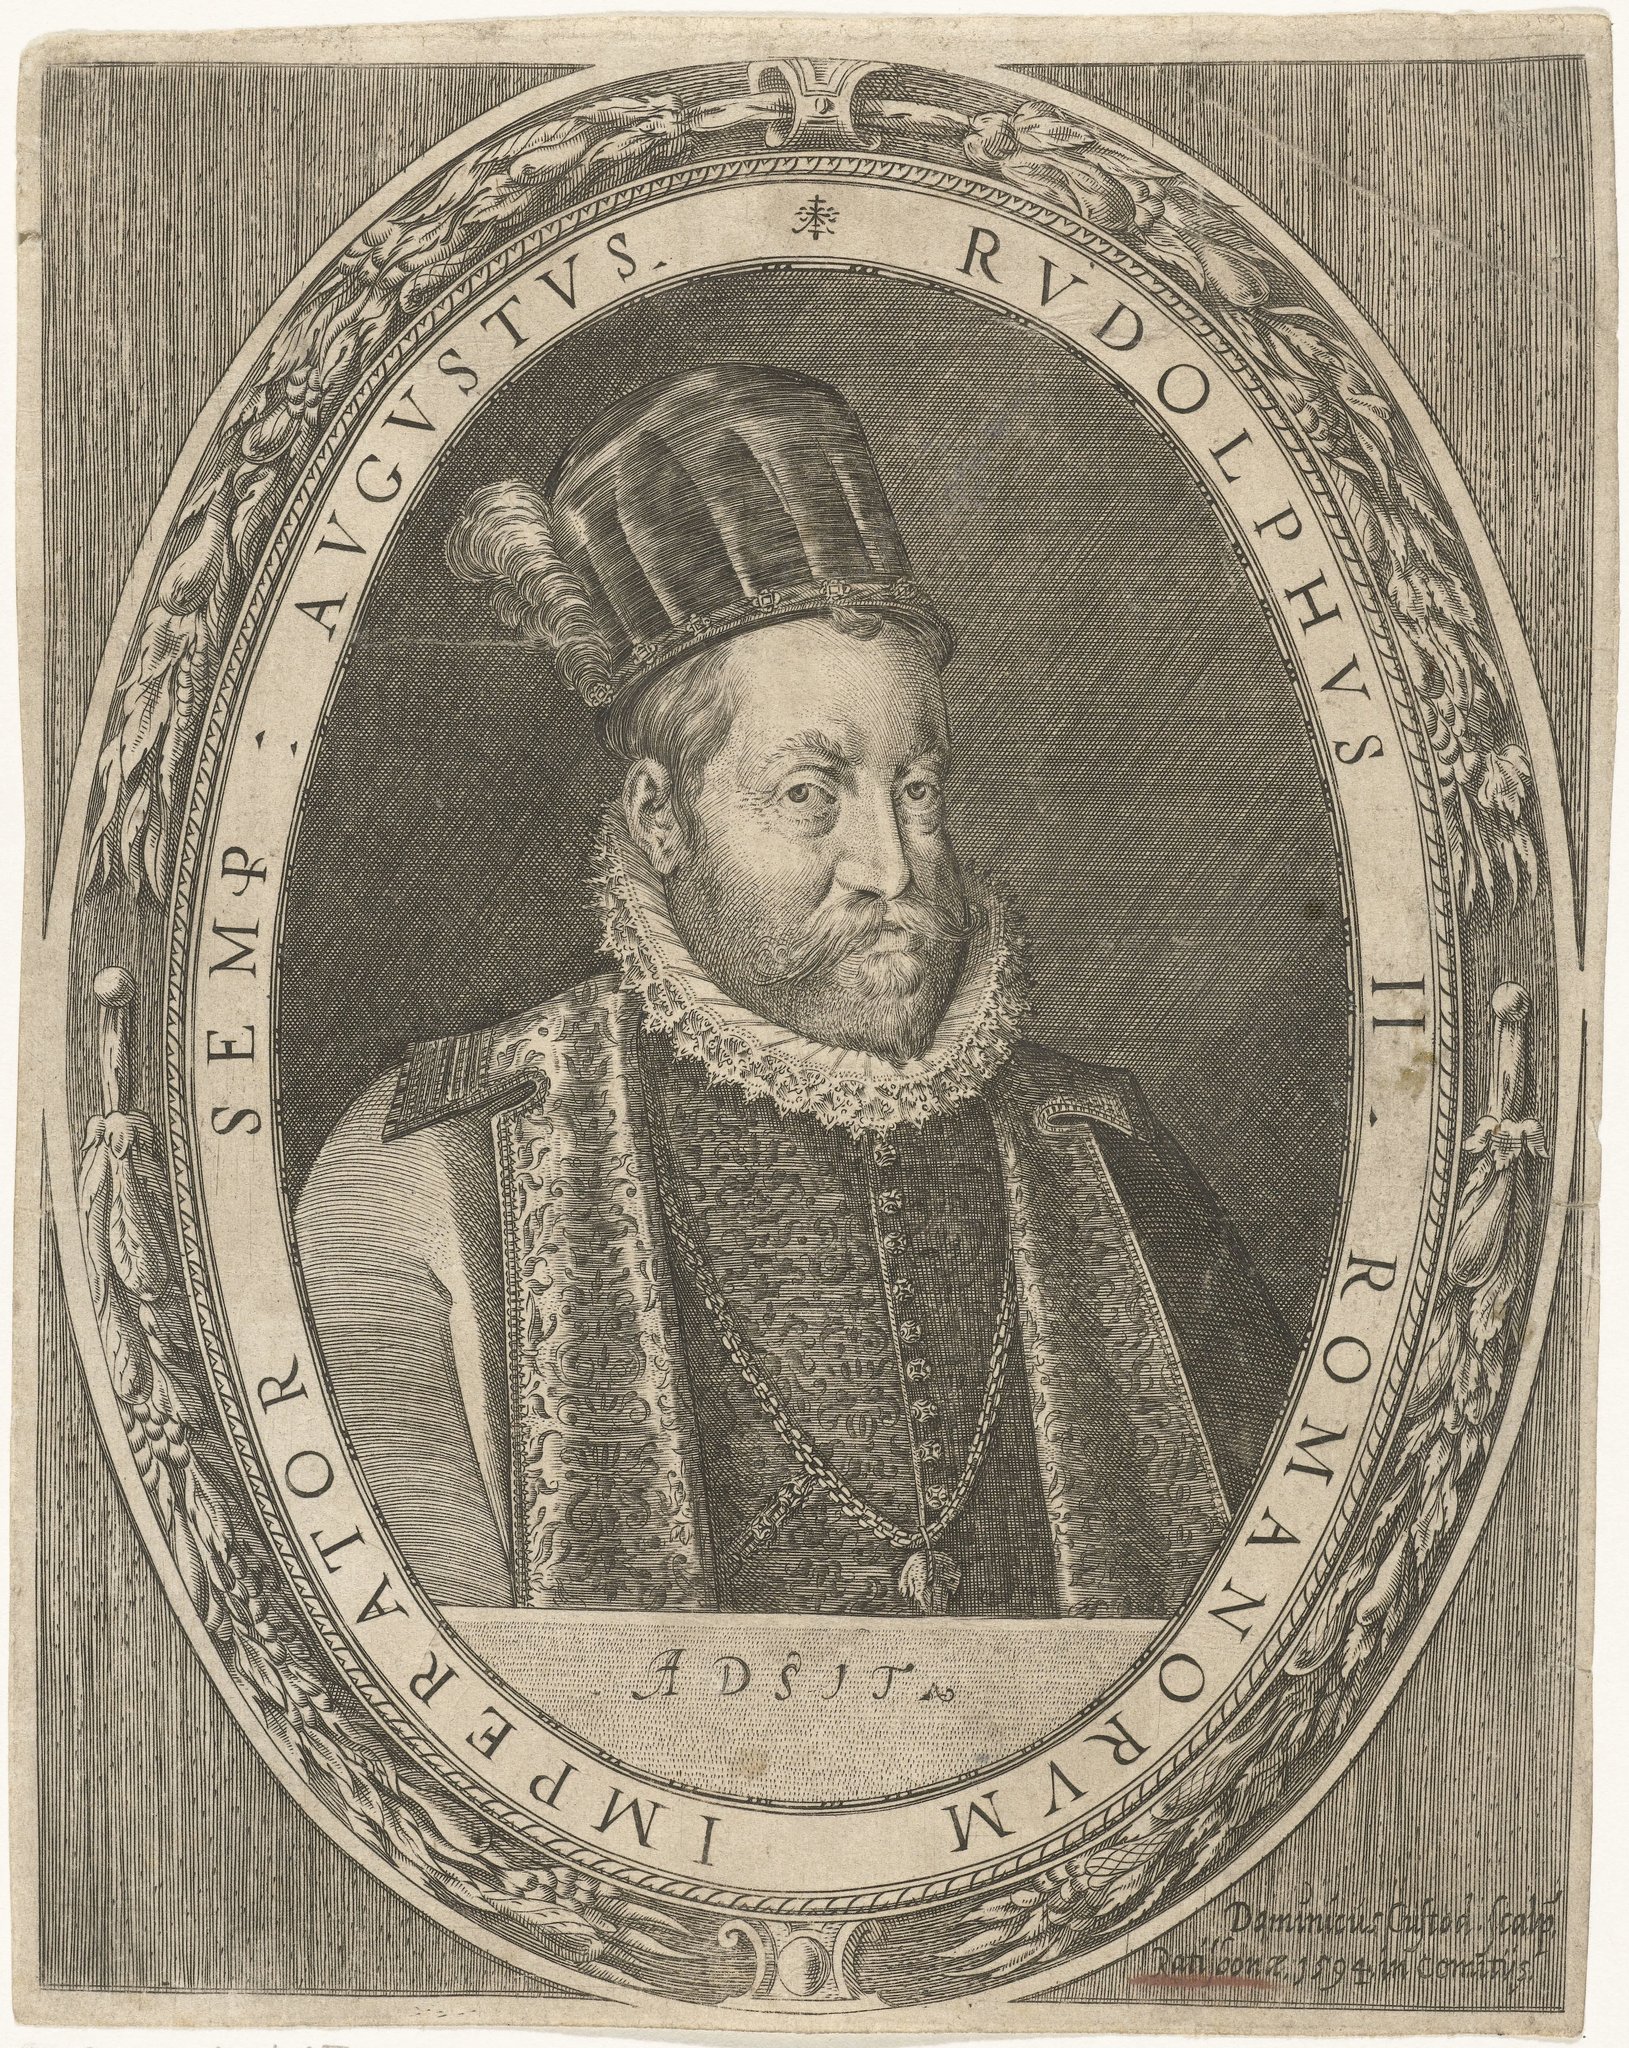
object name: print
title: Portret van keizer Rudolf II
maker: dominicus custos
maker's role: print maker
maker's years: 1560-1615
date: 1594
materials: paper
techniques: engraving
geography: regensburg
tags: vienna, rudolf ii van habsburg (duits keizer)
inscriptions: collector's mark: Lugt 2228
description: Portret van keizer Rudolf II, in ovaal met randschrift. Rudlof draagt de ketting van de Orde van het Gulden Vlies om zijn nek.